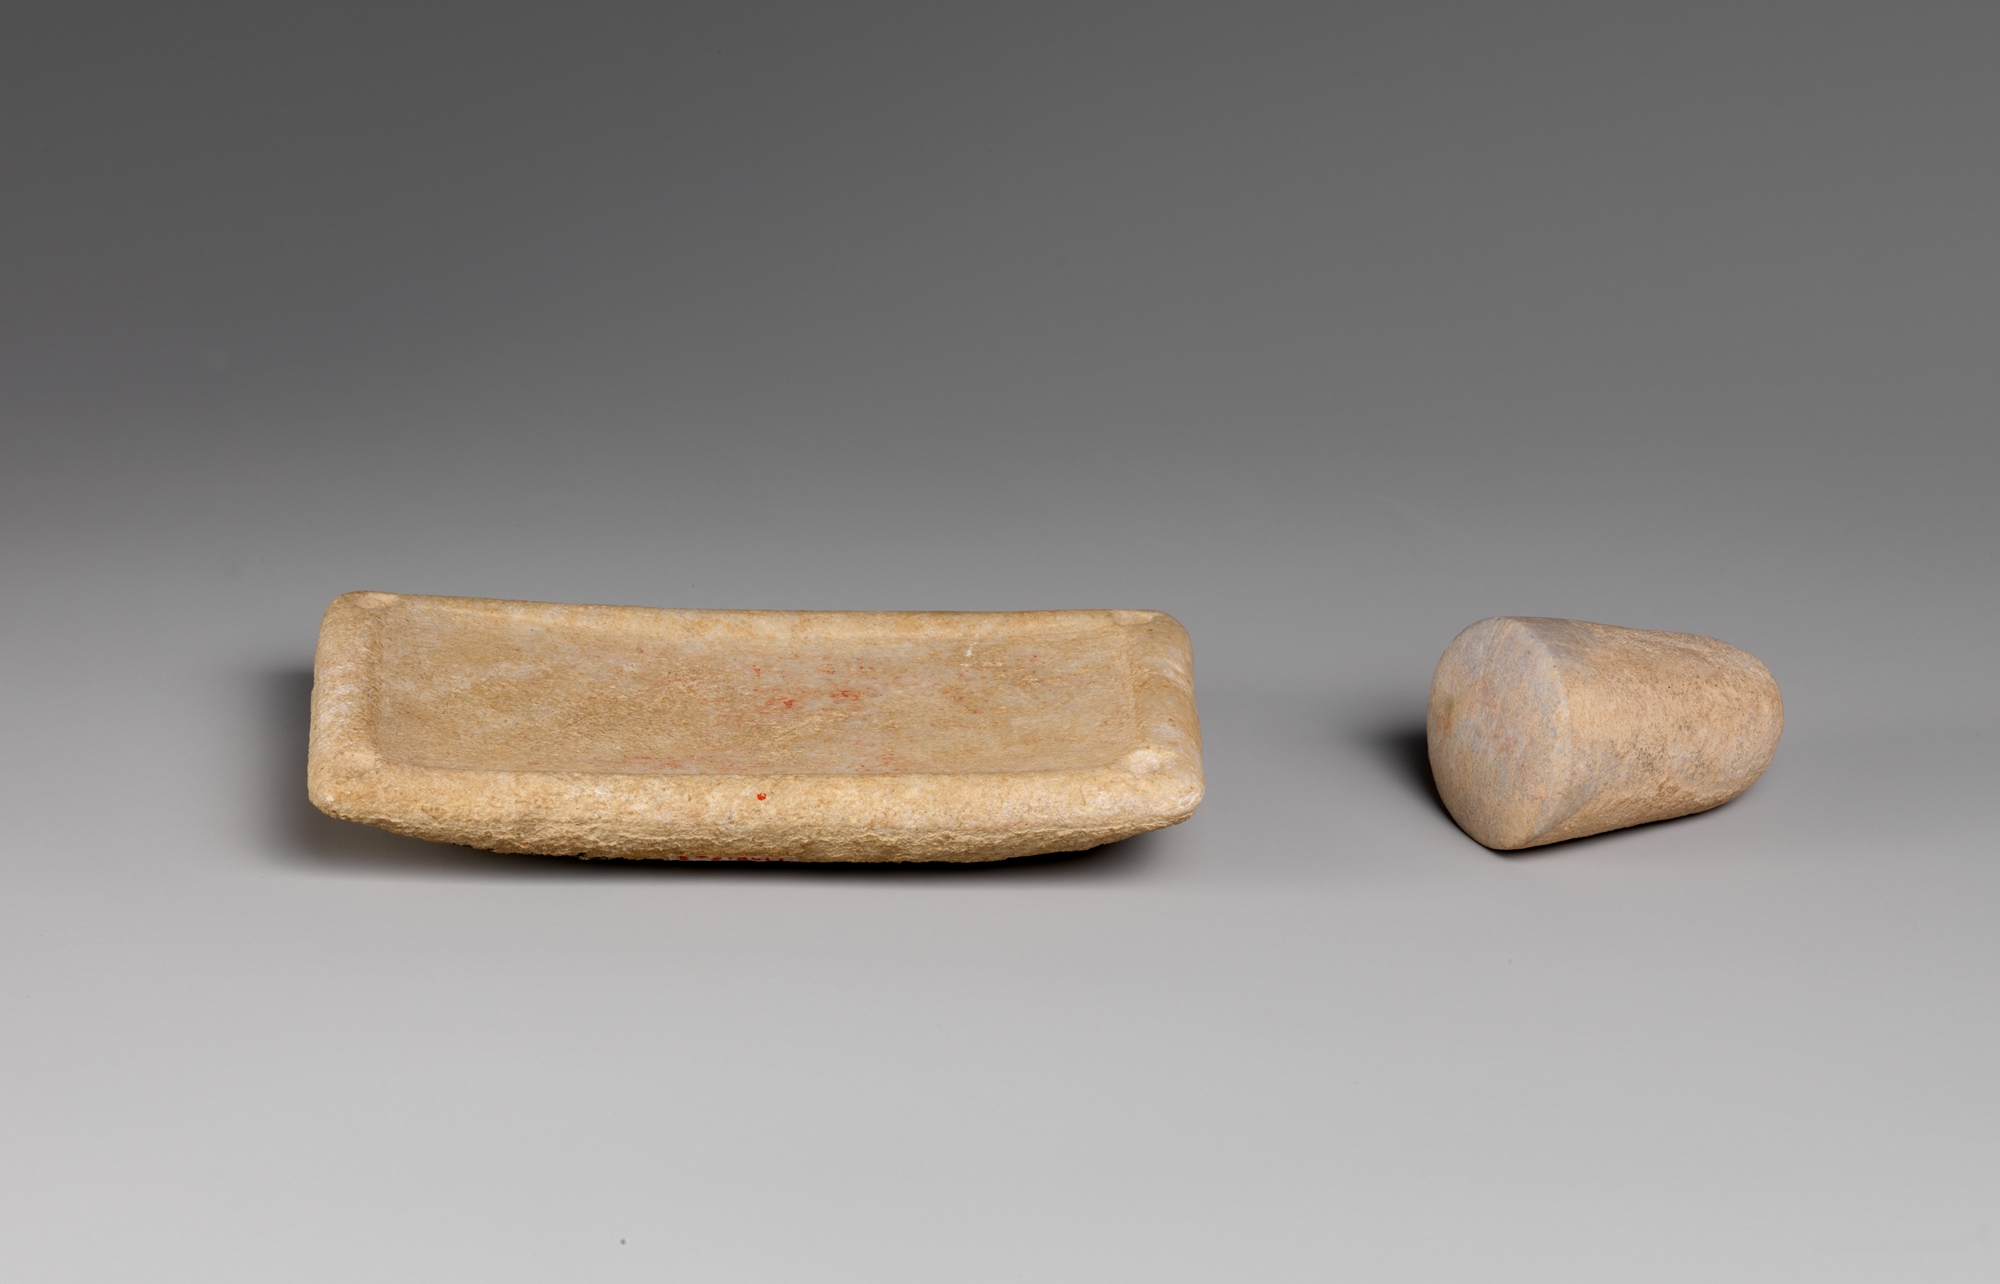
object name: palette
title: Marble palette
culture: cycladic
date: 3000-2800 BCE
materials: marble